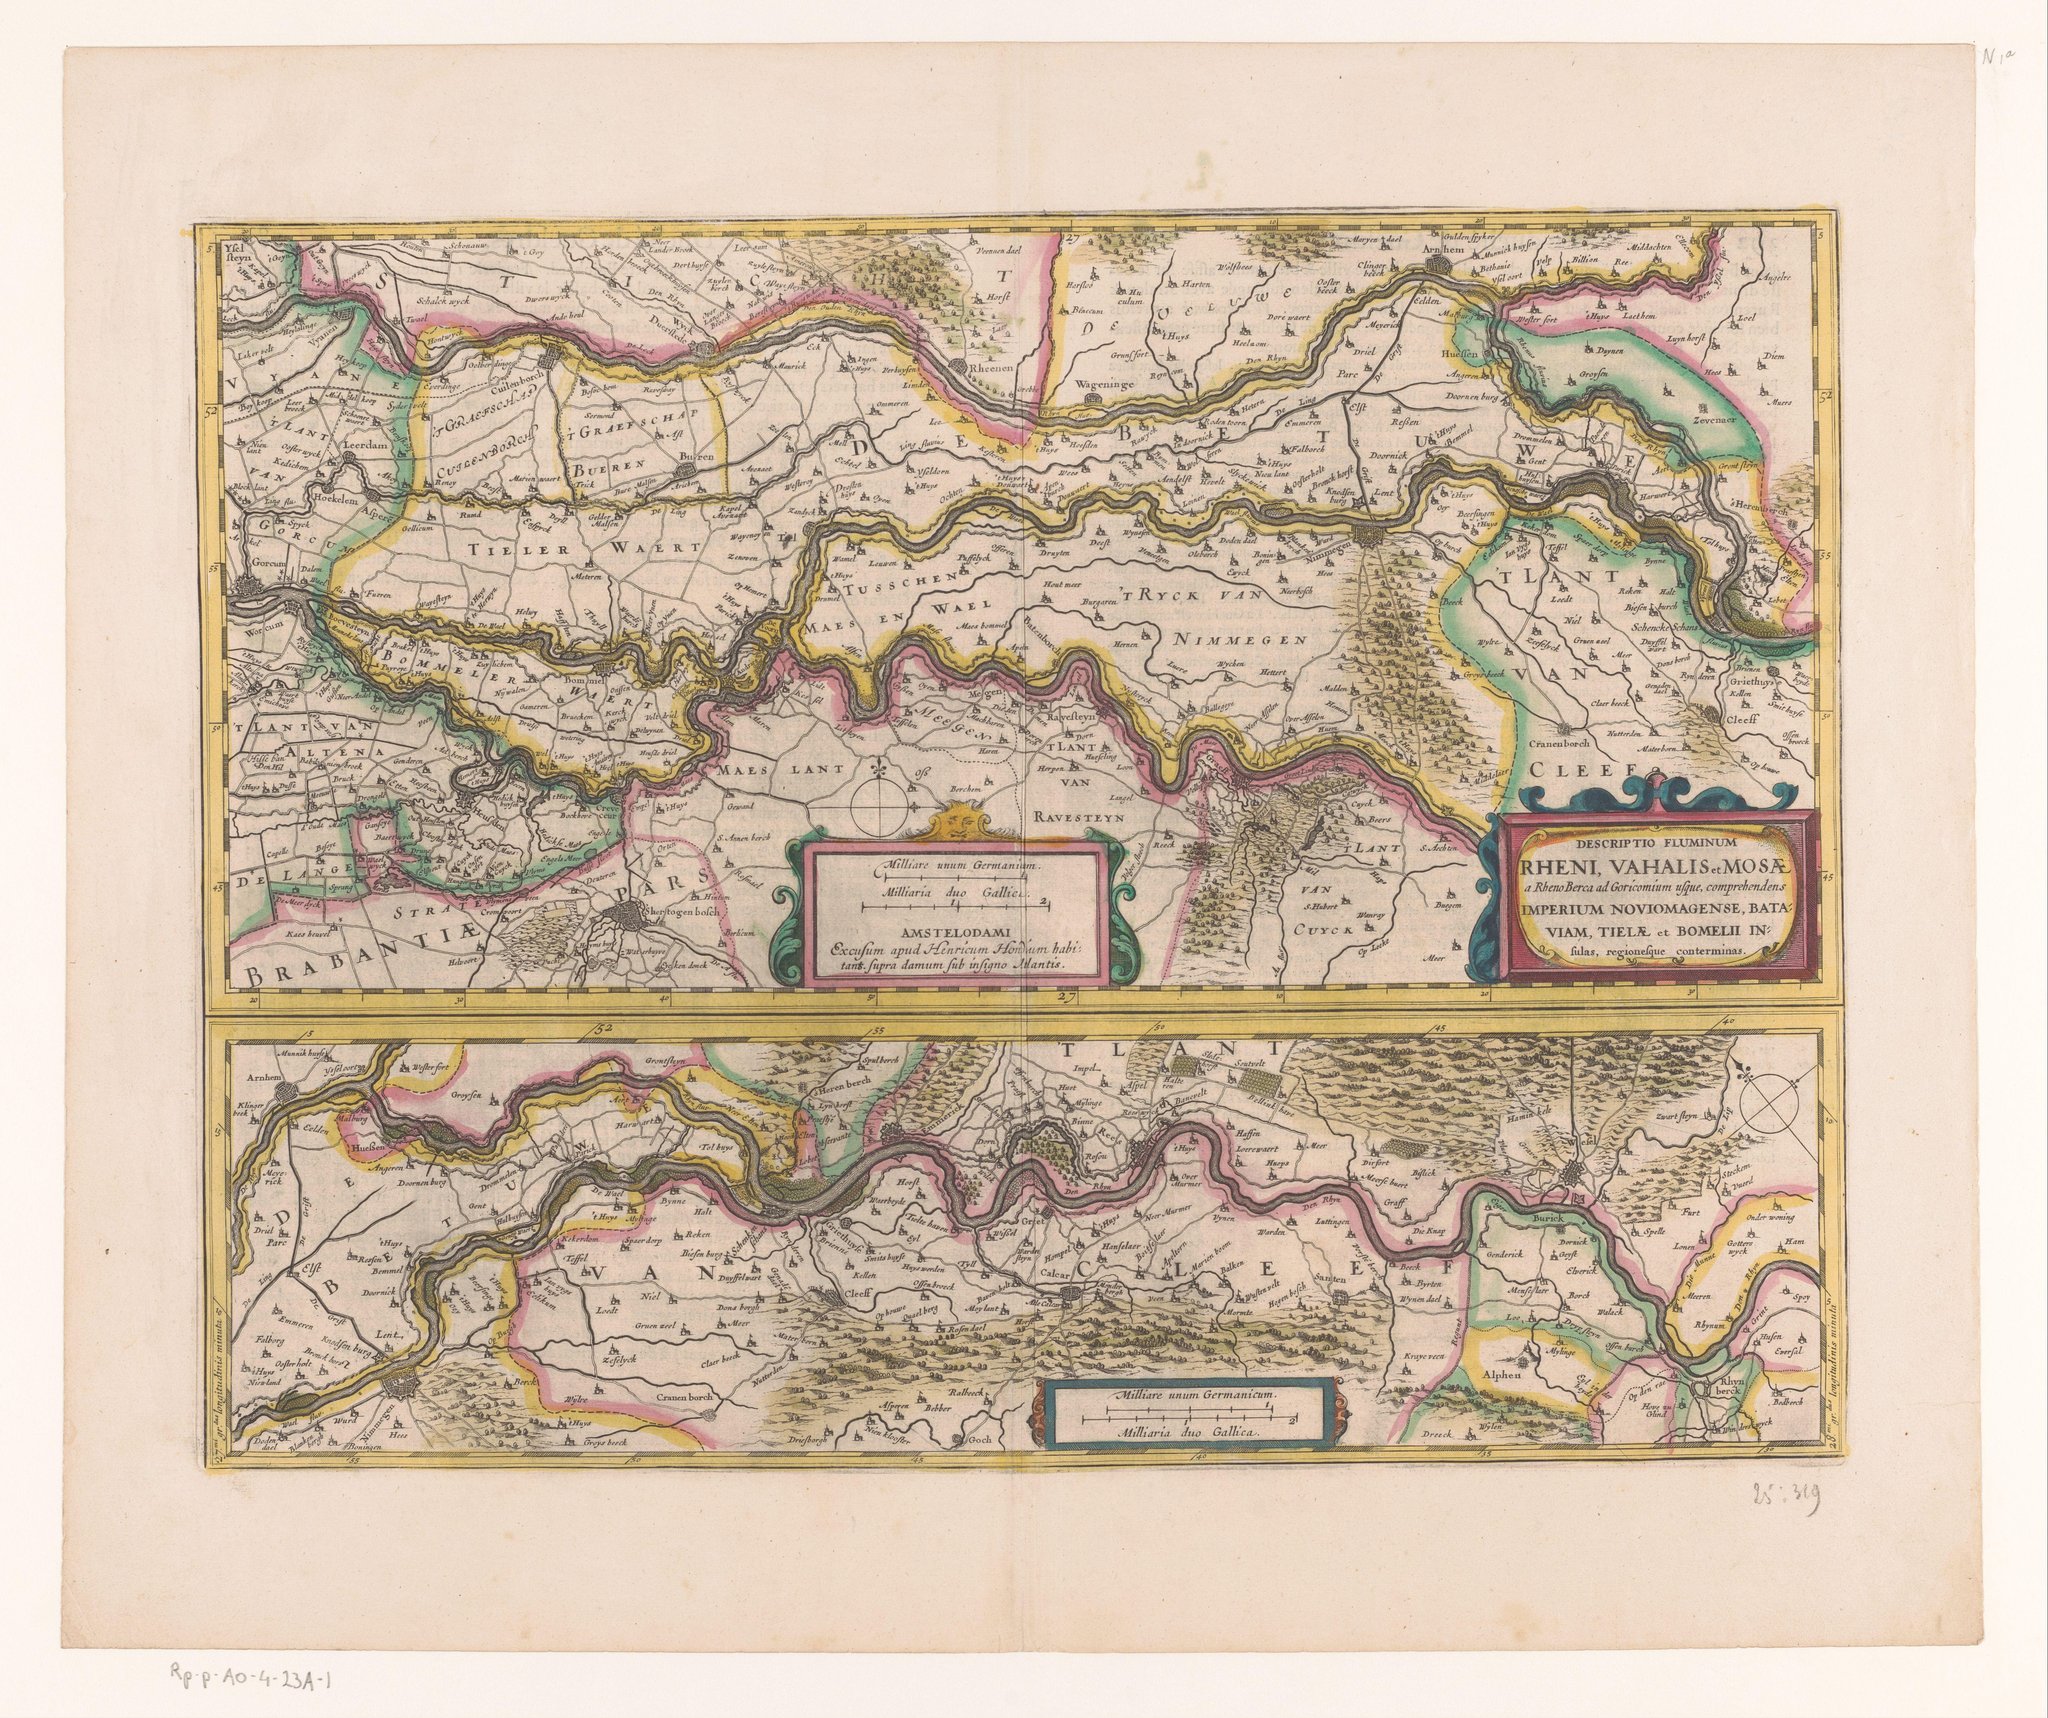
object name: print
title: Descriptio fluminum Rheni, Vahalis et Mosae a Rheno Berca ad (...)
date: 1633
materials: paper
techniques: engraving, etching, hand coloring, letterpress printing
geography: amsterdam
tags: maps of separate countries or regions, river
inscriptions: collector's mark: Lugt 2228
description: De kaart bestaat uit twee delen. Rechts in het midden de titelcartouche. Onder in het midden van het bovenste deel een cartouche met twee schaalstokken: 1 Milliare unum Germanium / 2 Milliaria duo Gallica. Onder in het midden van het onderste deel een cartouche met dezelfde schaalstokken. De kaart is voorzien van een gradenverdeling langs de randen. Met Franse tekst op verso.